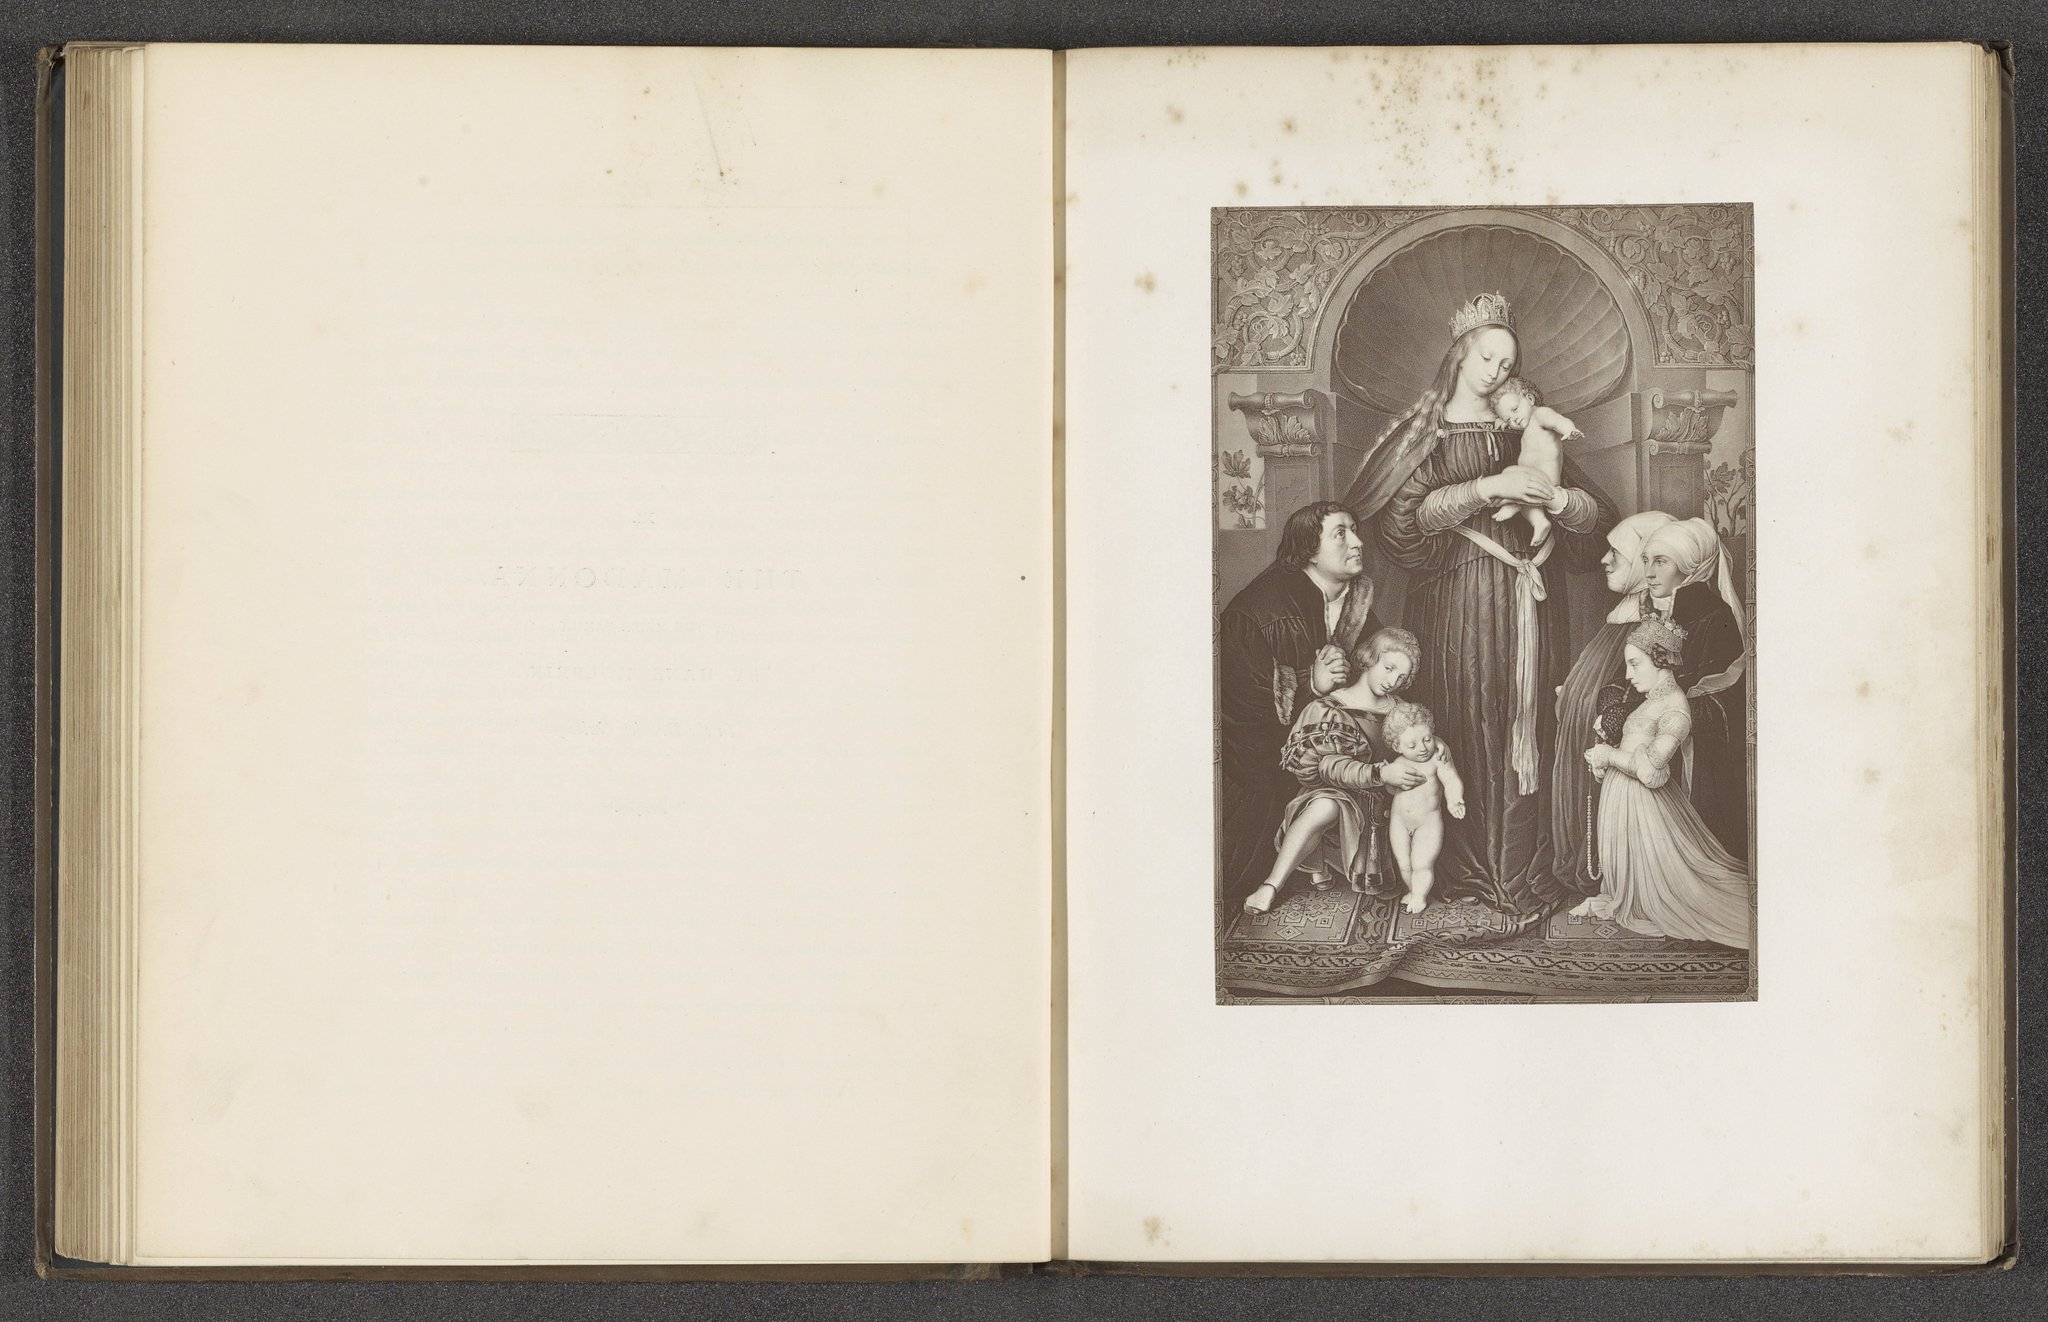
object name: page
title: Fotoreproductie van een prent naar het schilderij Darmstadt Madonna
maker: Anonymous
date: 1859-1869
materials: paper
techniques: woodburytype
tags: madonna: i.e. mary with the christ-child (+ donor(s), supplicant(s), whether or not with patron saint(s))